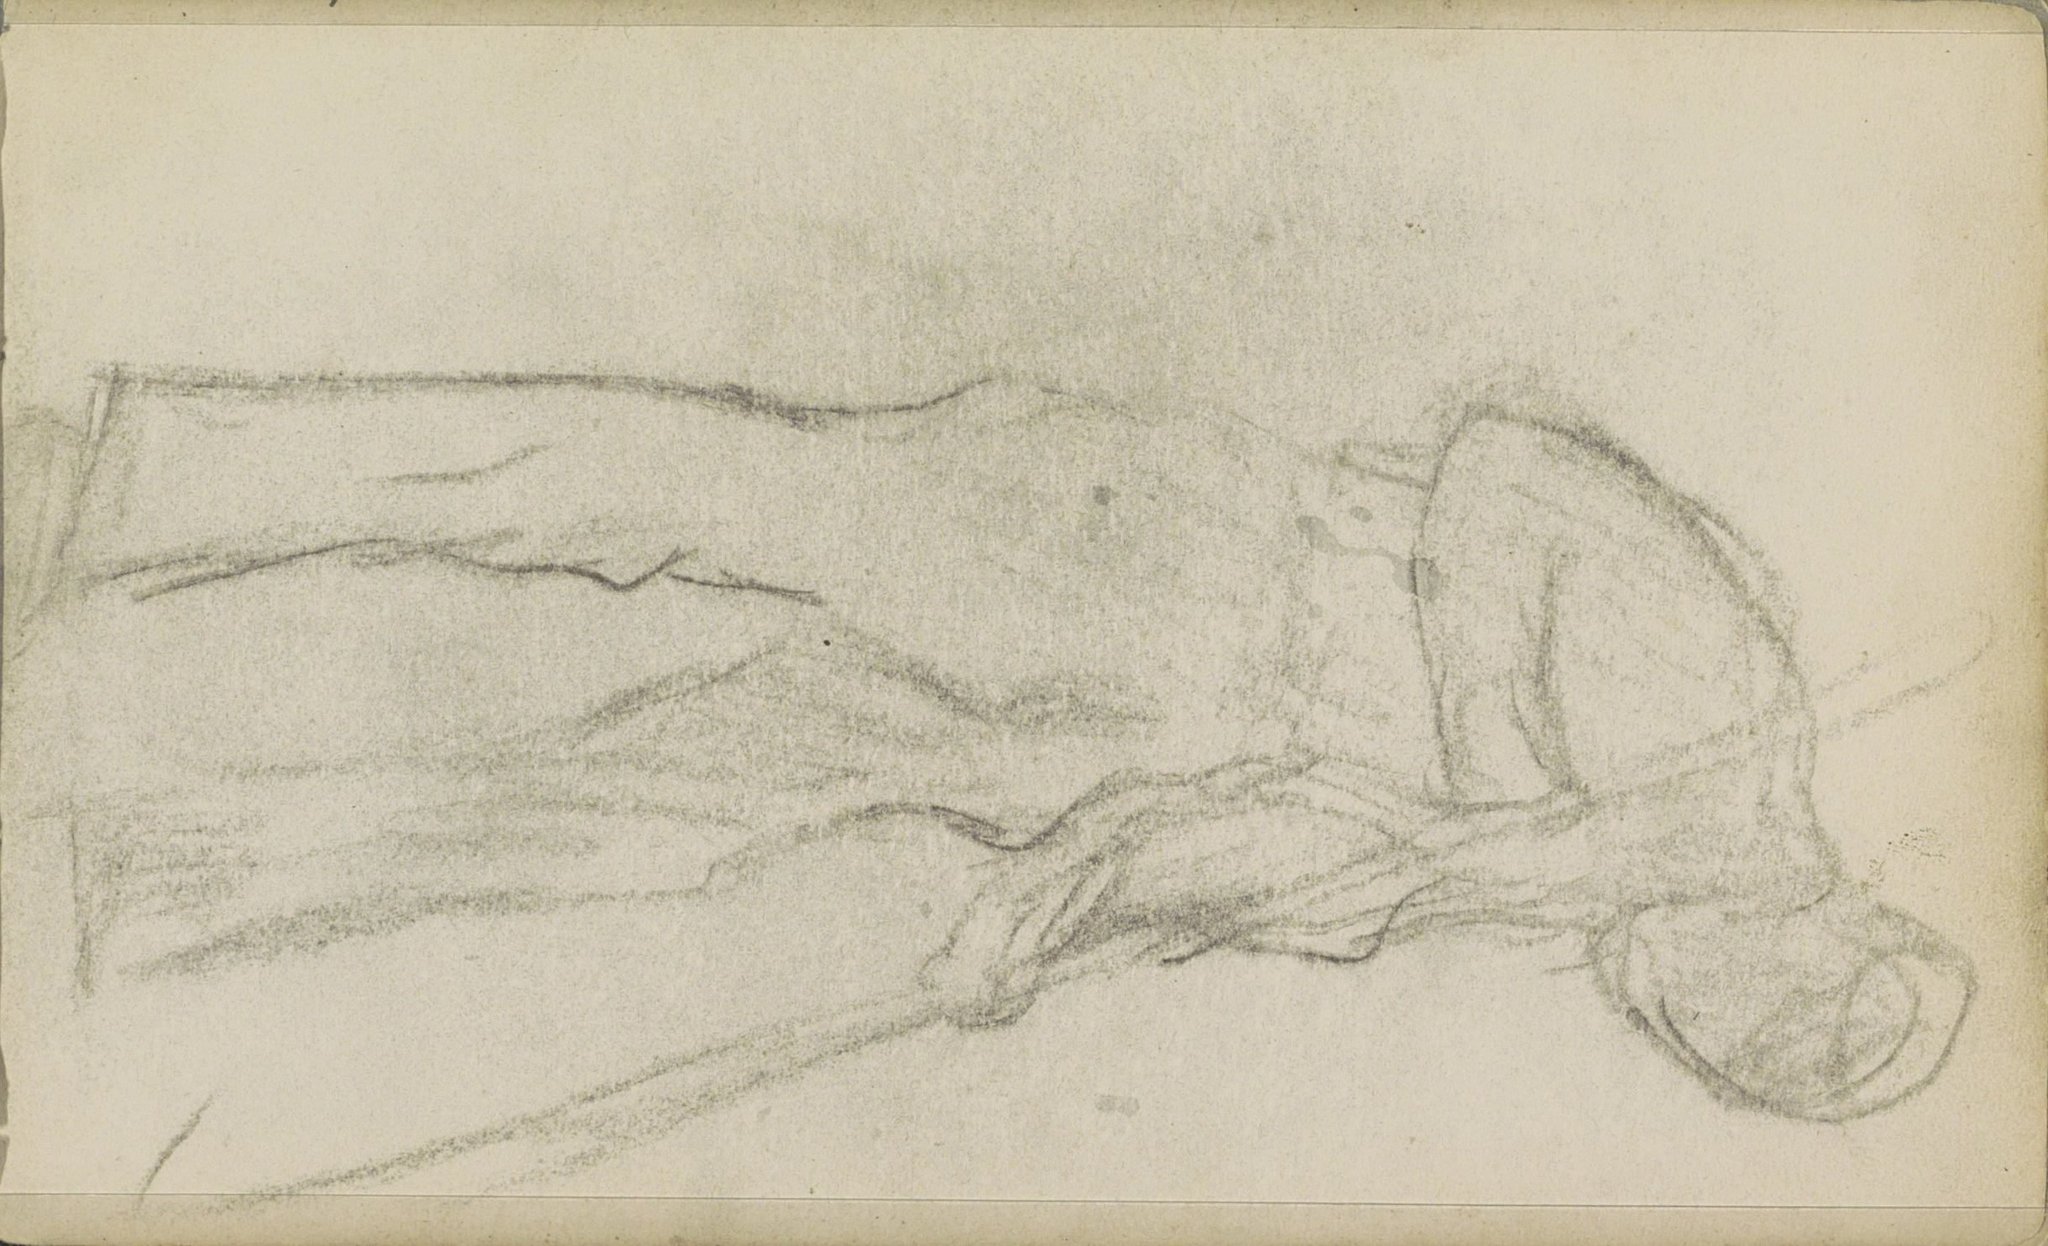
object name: sketchbook leaf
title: Man met een stuk landbouwgereedschap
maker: jozef israëls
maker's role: draughtsman, painter, print maker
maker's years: 1824-1911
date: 1834-1911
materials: chalk, paper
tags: agricultural implements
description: Vermoedelijk een arbeider met een schoffel. Blad 6 recto uit een schetsboek met 42 bladen.